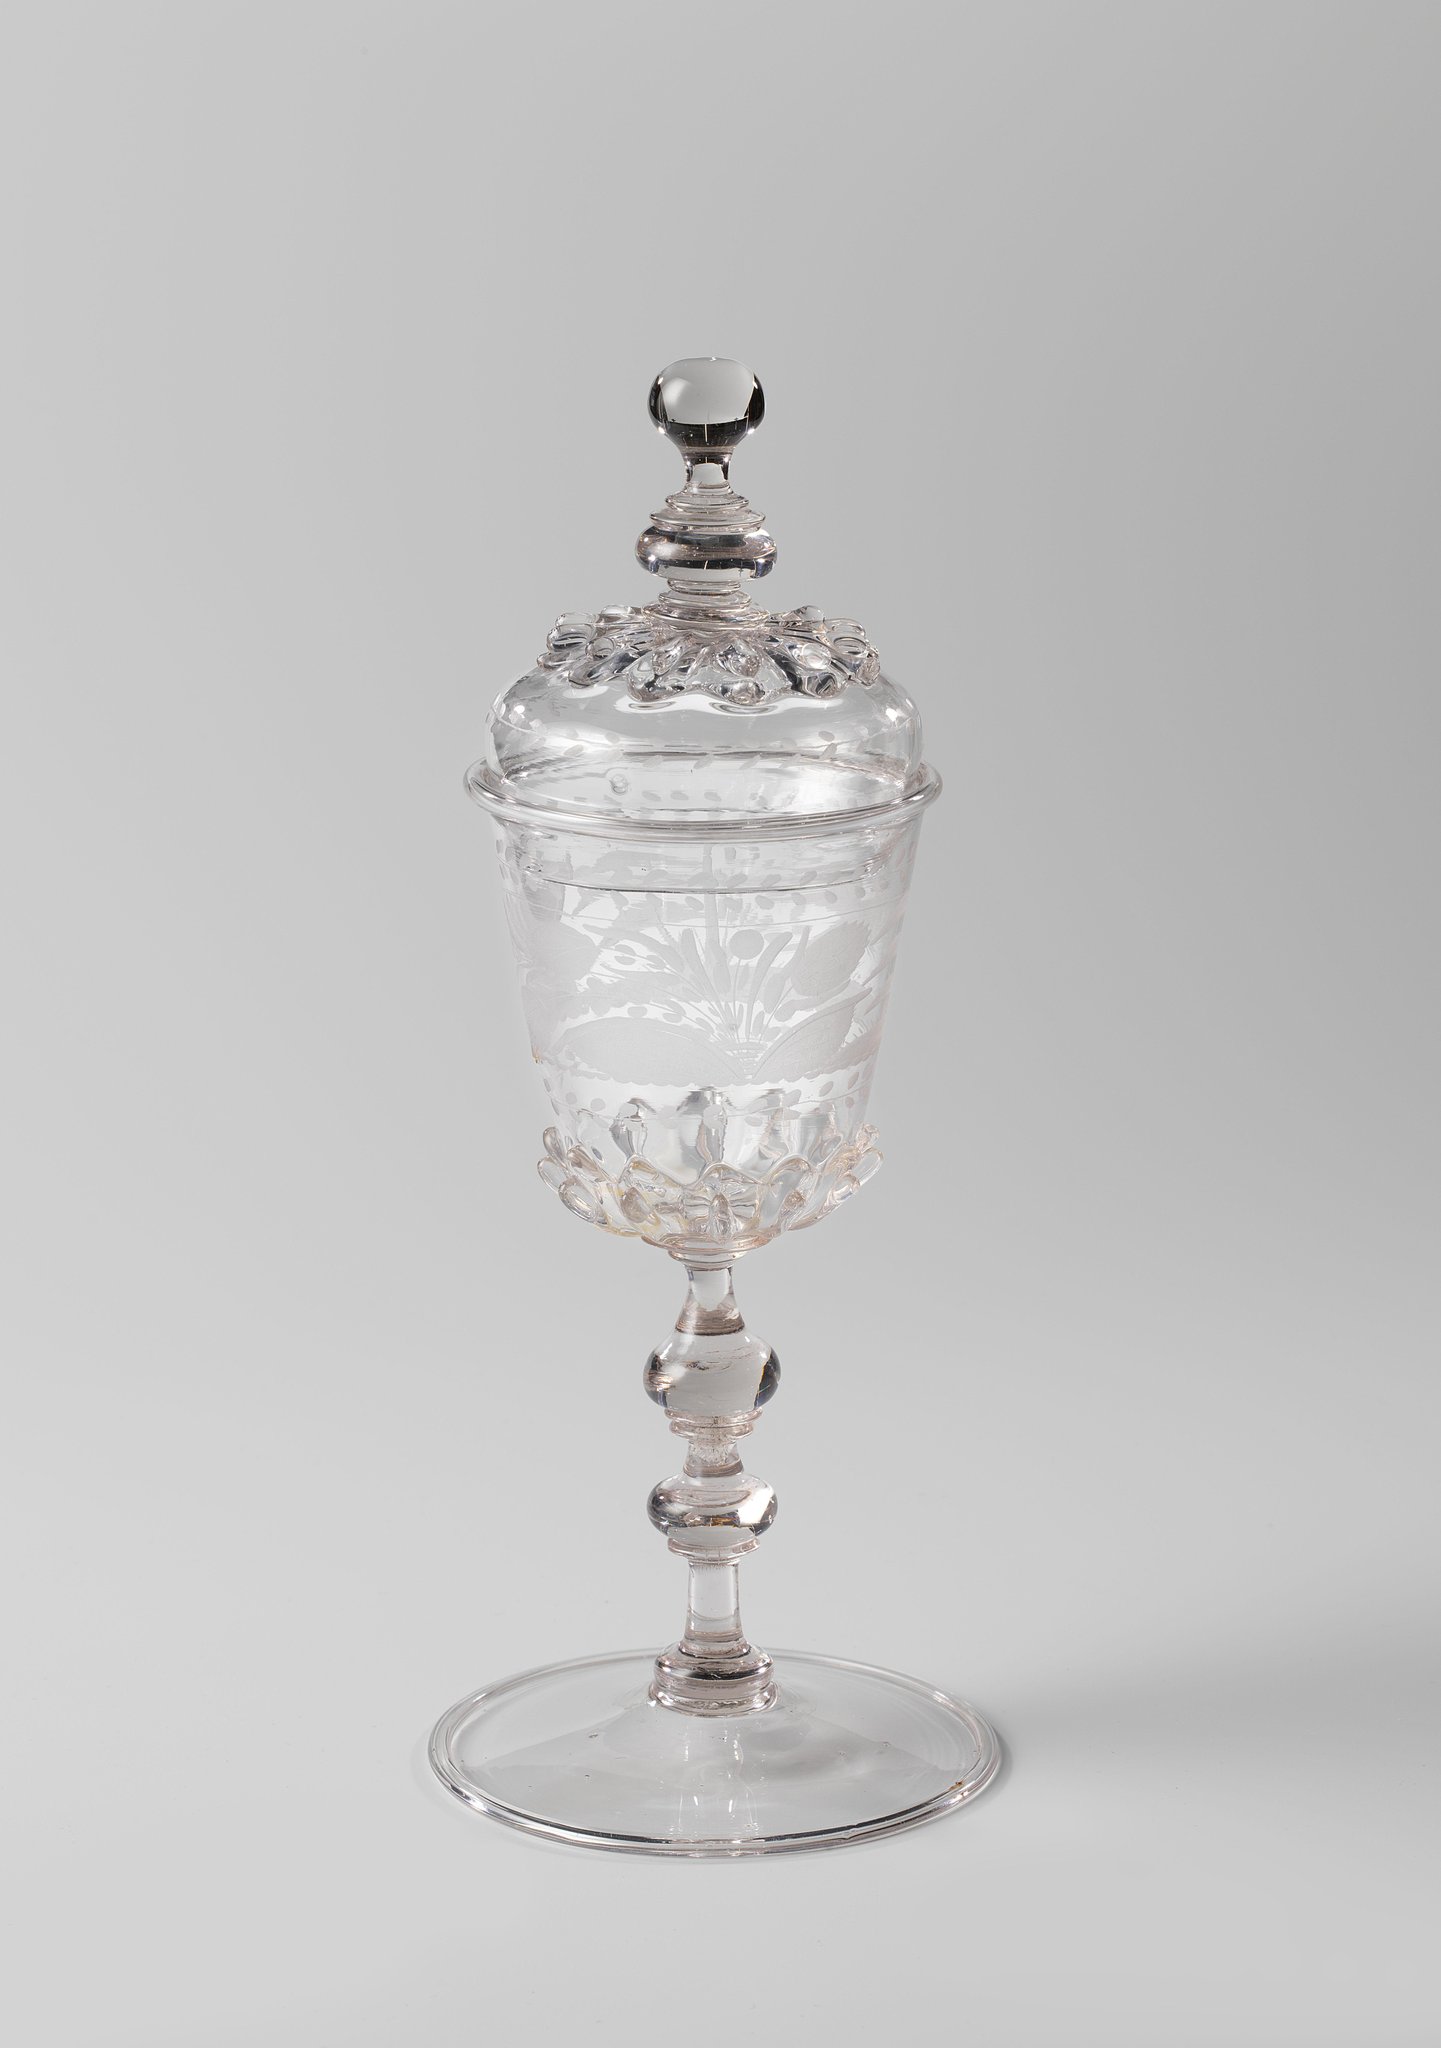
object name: lid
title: Deksel van bokaal met bladversiering en een vogel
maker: Anonymous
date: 1690-1700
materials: glass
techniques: glassblowing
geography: bohemia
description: Deksel van beker van helder, kleurloos glas, met op de kelk een gegraveerde bladversiering waartussen een vogel.